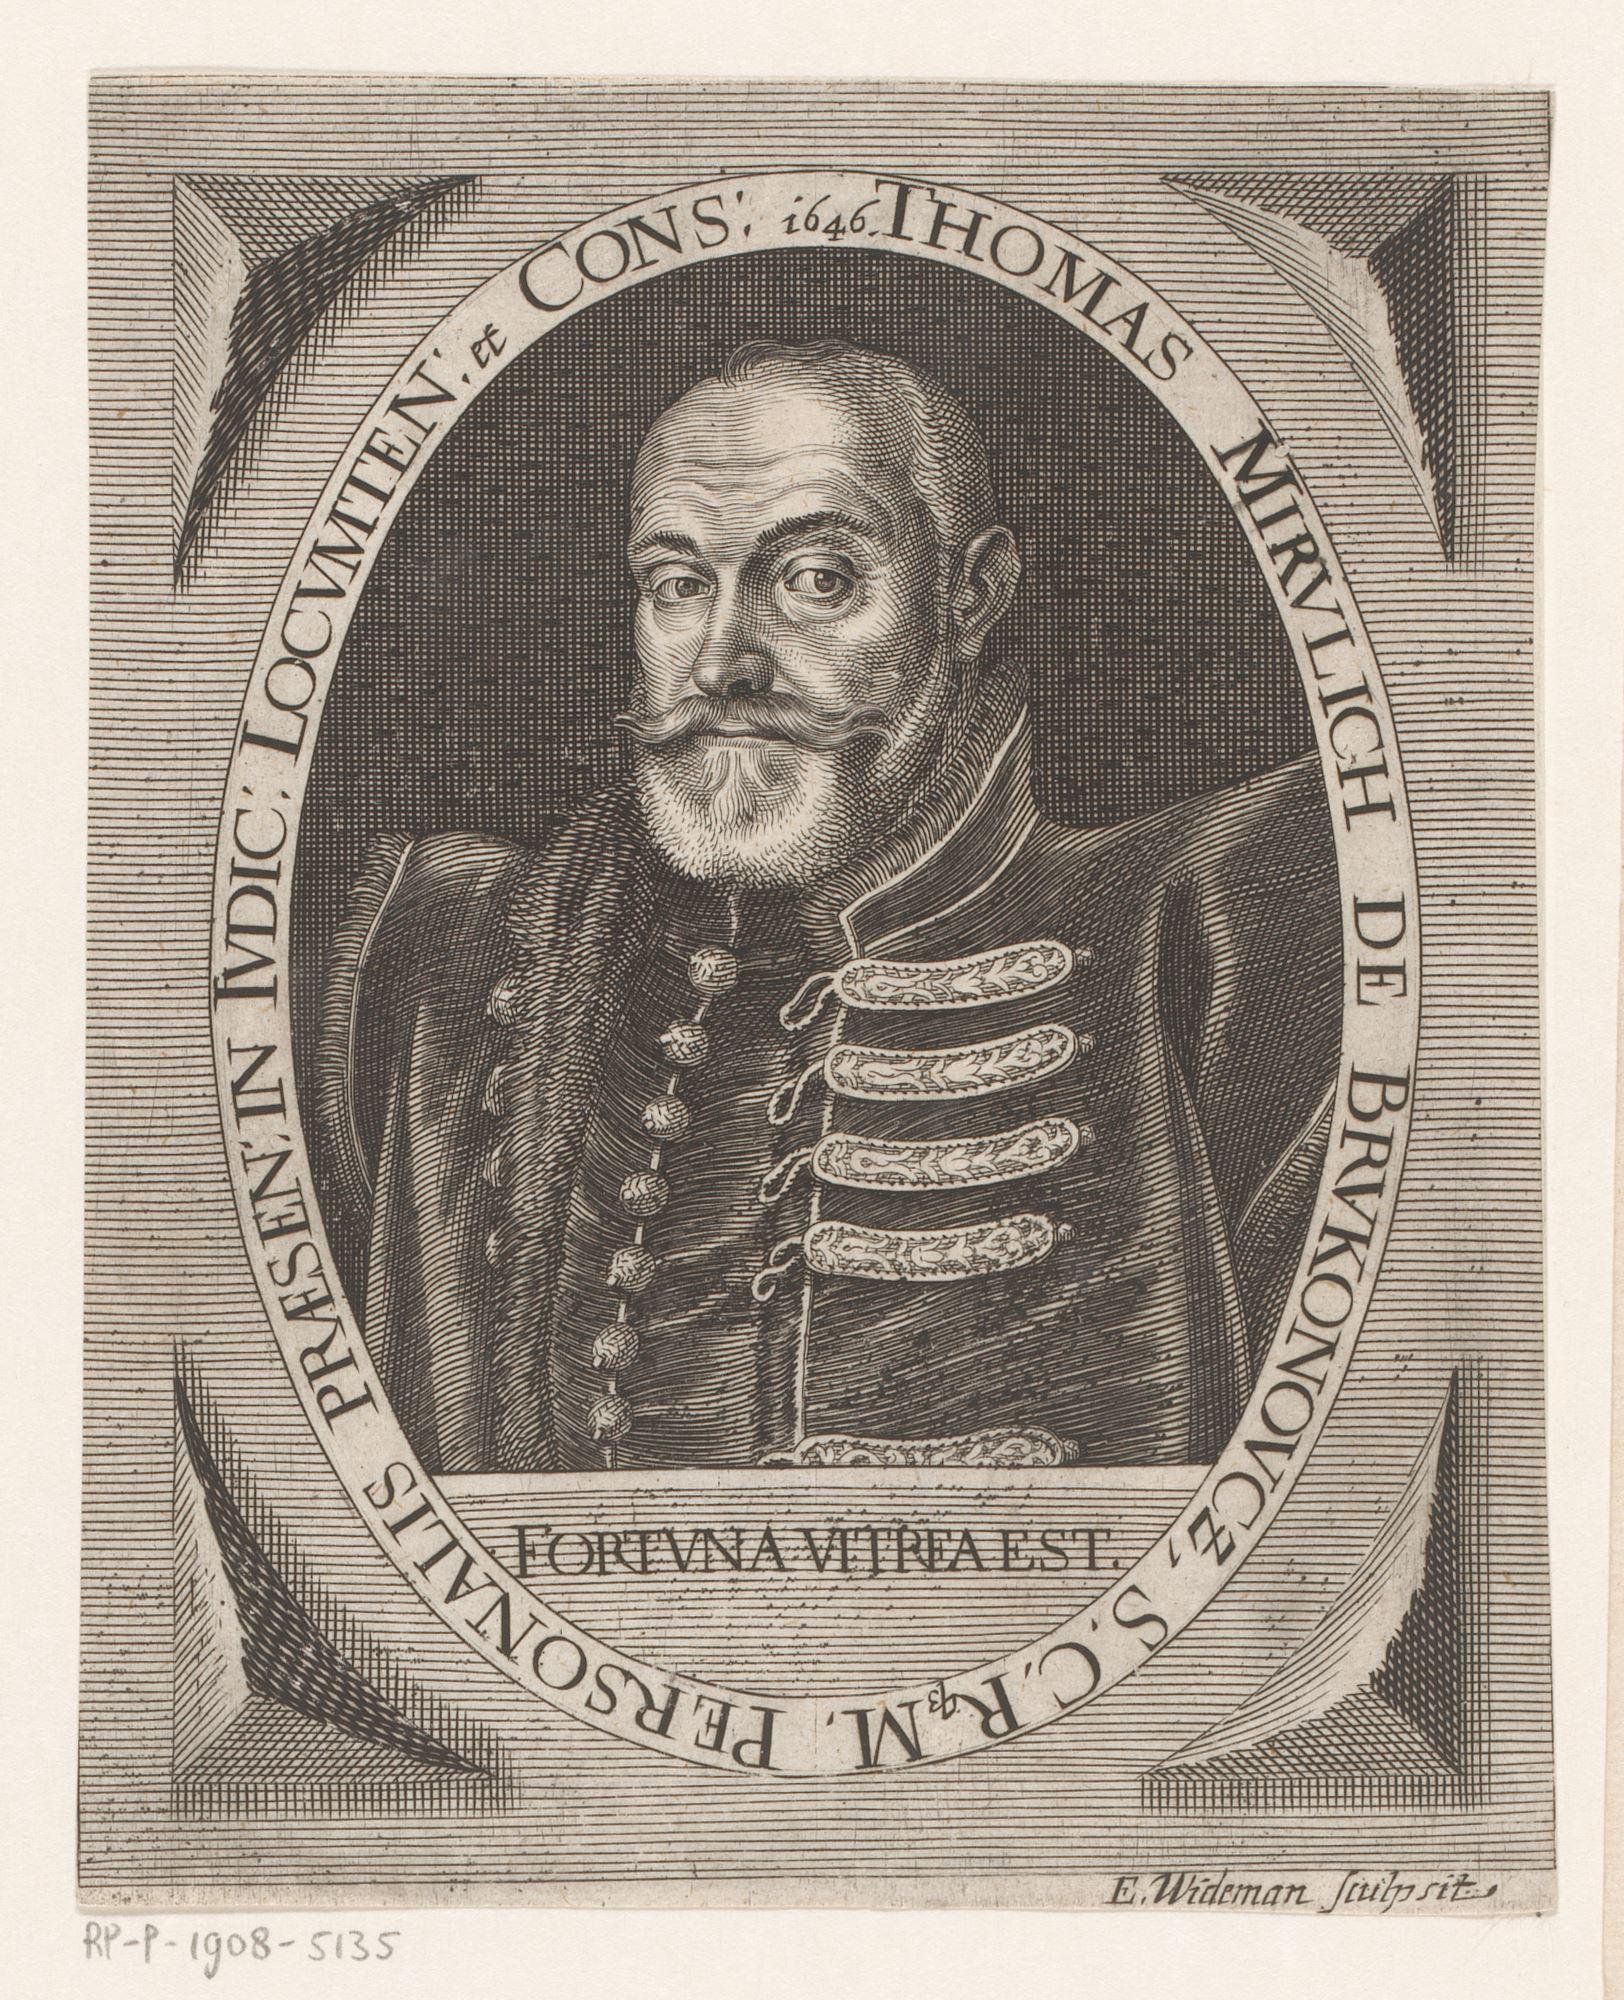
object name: print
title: Portret van Thomas de Brukonovcz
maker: elias widemann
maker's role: print maker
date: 1646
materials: paper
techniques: engraving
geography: vienna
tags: historical persons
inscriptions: collector's mark: Lugt 2228